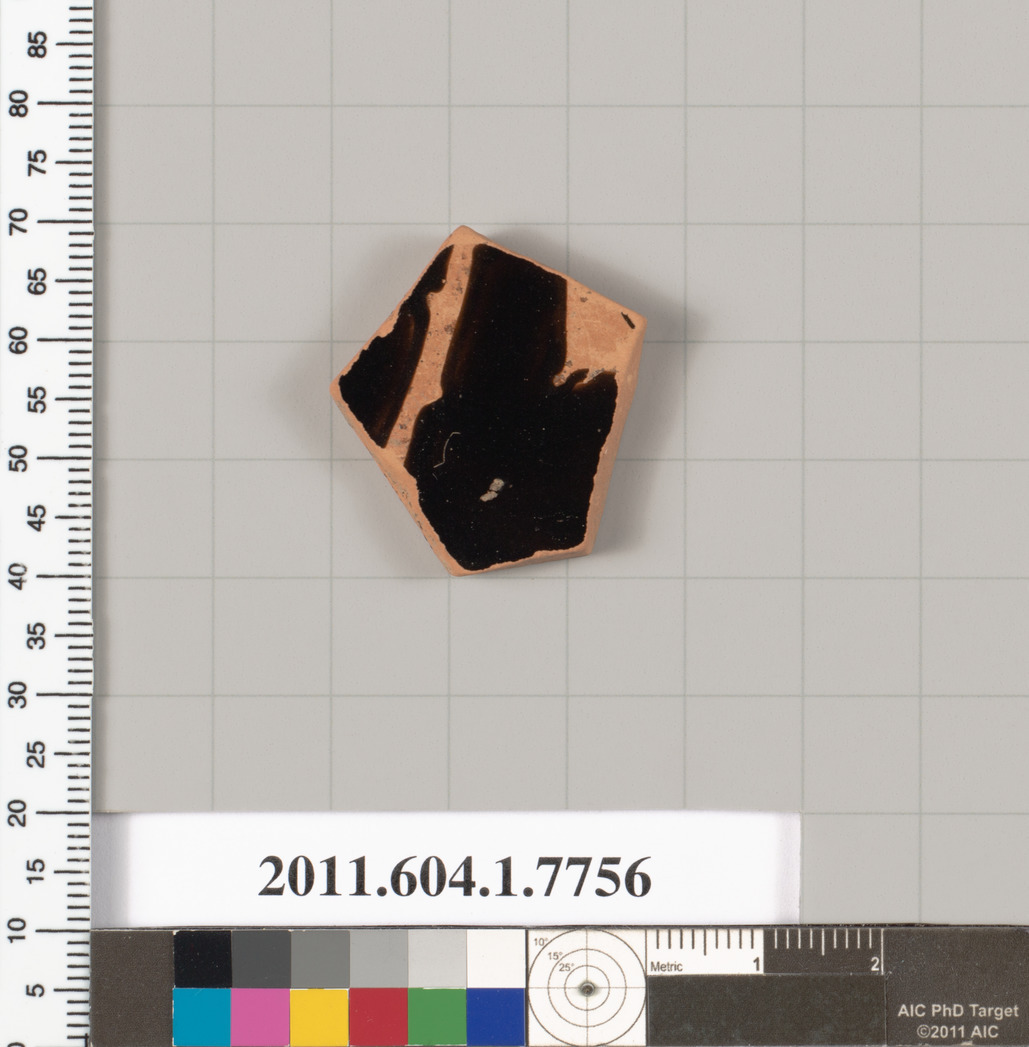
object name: kylix fragment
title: Terracotta fragment of a kylix (drinking cup)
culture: greek, attic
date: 460-450 BCE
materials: terracotta